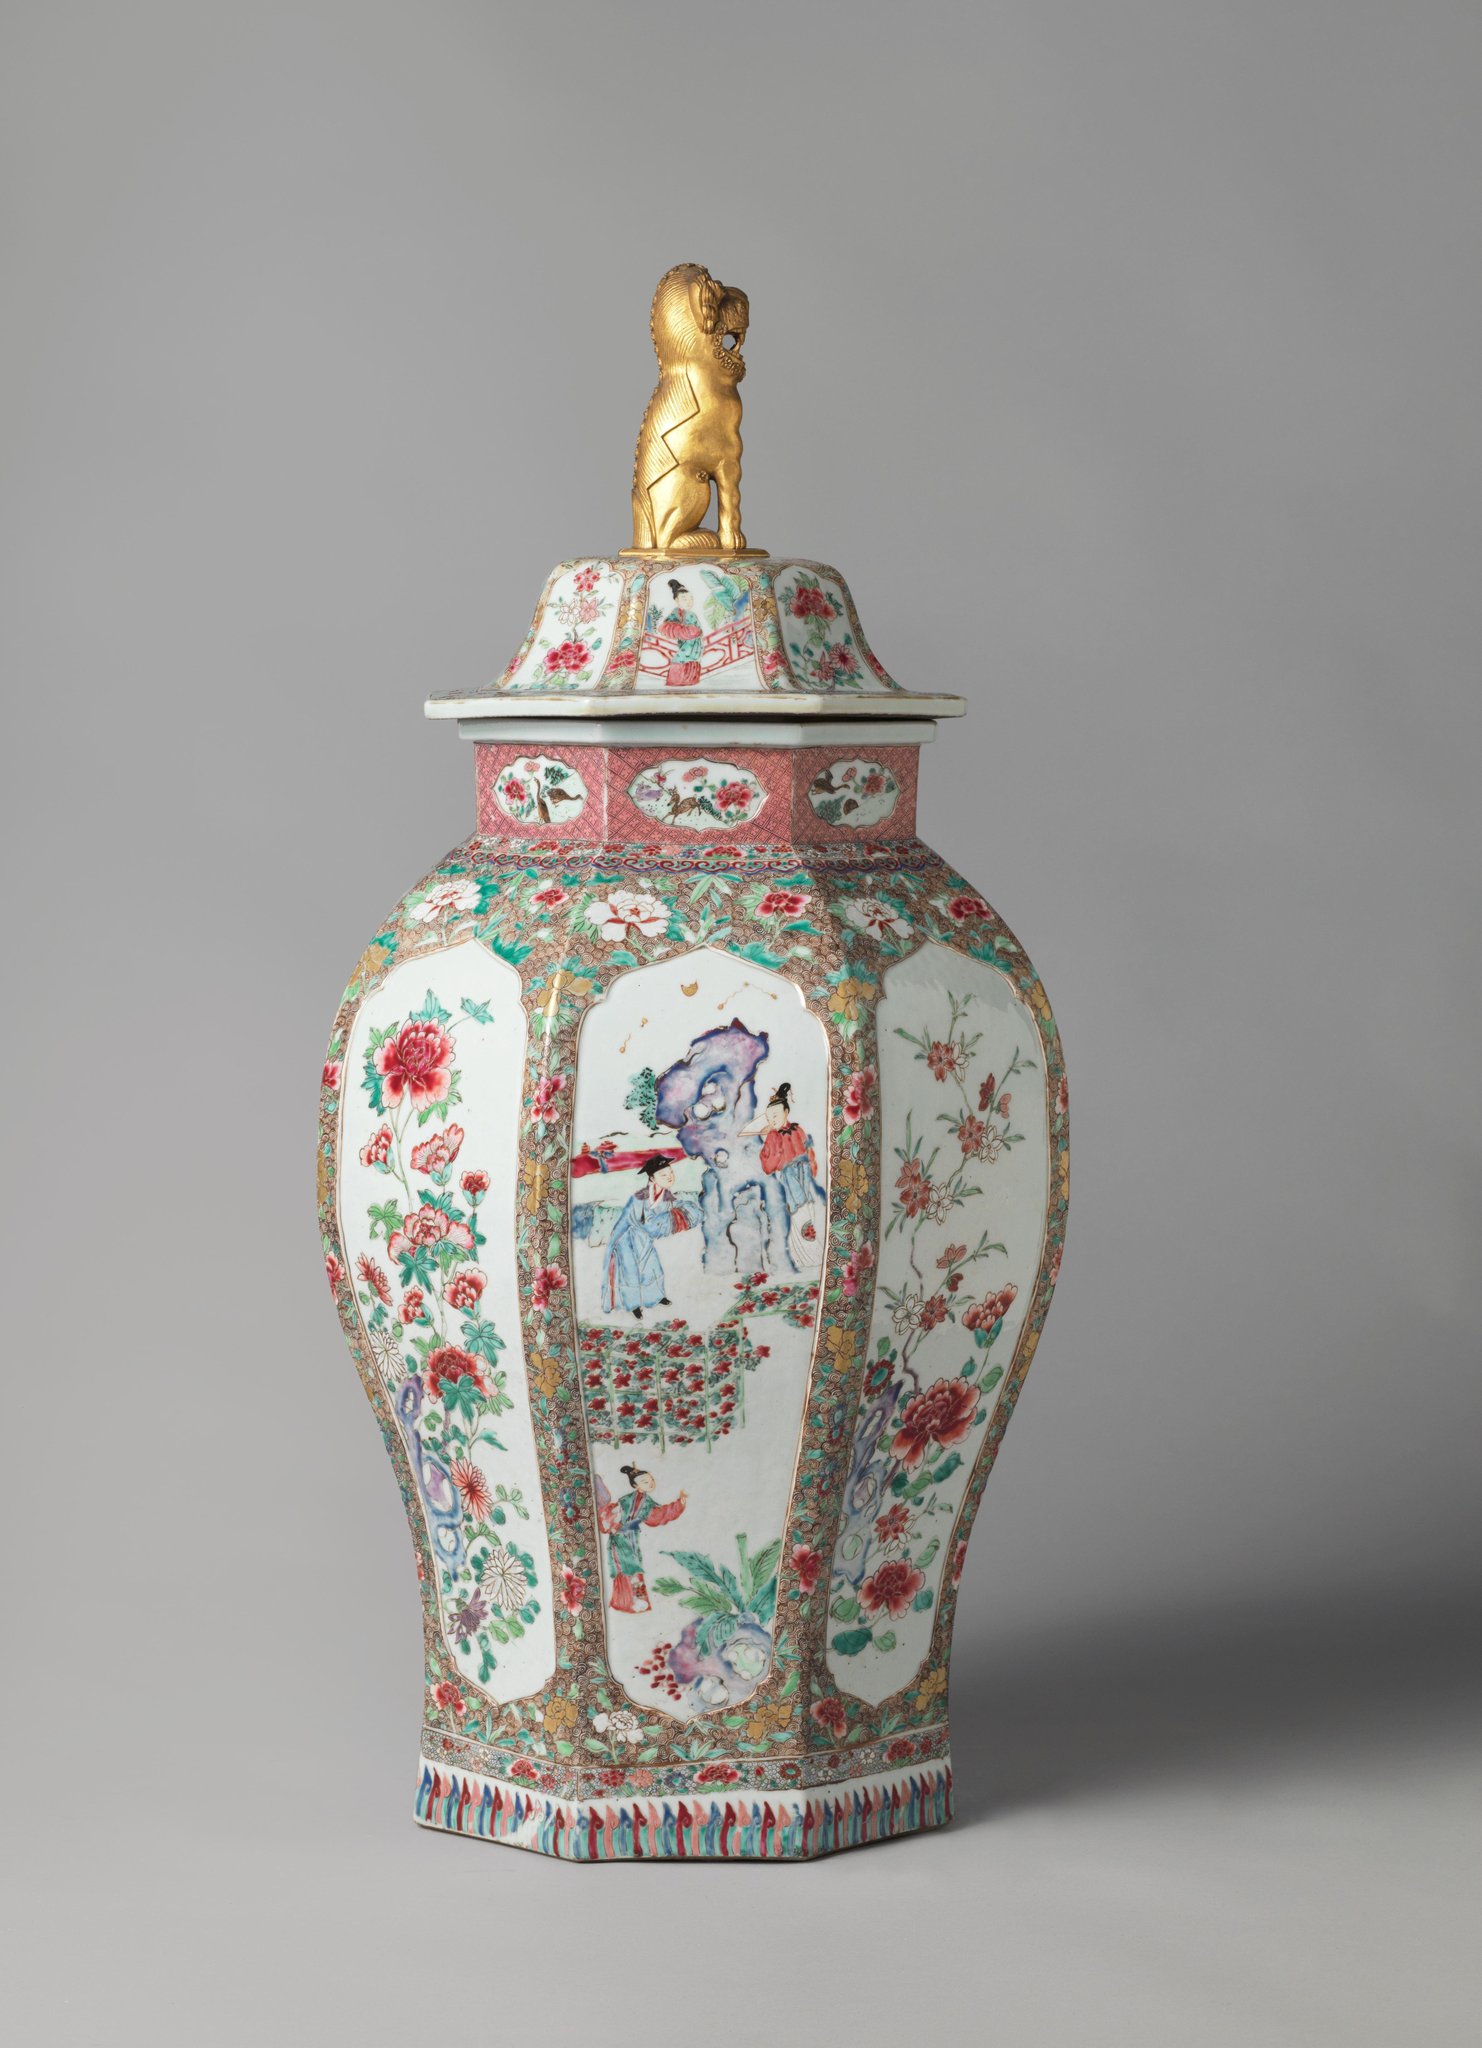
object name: lid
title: Octagonal cover with flowering plants and figures in a fenced garden in panels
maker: Anonymous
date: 1800-1899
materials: glaze, gold, paint, porcelain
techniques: firing, forming, gilding, turning, vitrification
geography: china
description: Achthoekige deksel van porselein, beschilderd op het glazuur in blauw, rood, roze, groen, paars, zwart en goud. Bedekt met pioentakken tegen een achtergrond van een spiraal-patroon. Op elk van de acht zijden een uitgespaard, geschulpt cartouche met afwisselend bloemtakken (pioen, chrysant, aster, prunus) bij een rots of één of meerdere personen op een terras of in een omheinde tuin bij bloeiende planten en rotsen. De rand met acht vakken met bloeiende planten tegen een achtergrond van blauw kikkerdril. Dekselknop is in de vorm van een shishi (leeuwhond). Dekselknop is niet origineel. Deksel is onderdeel van kaststel AK-NM-11497. Famille rose.